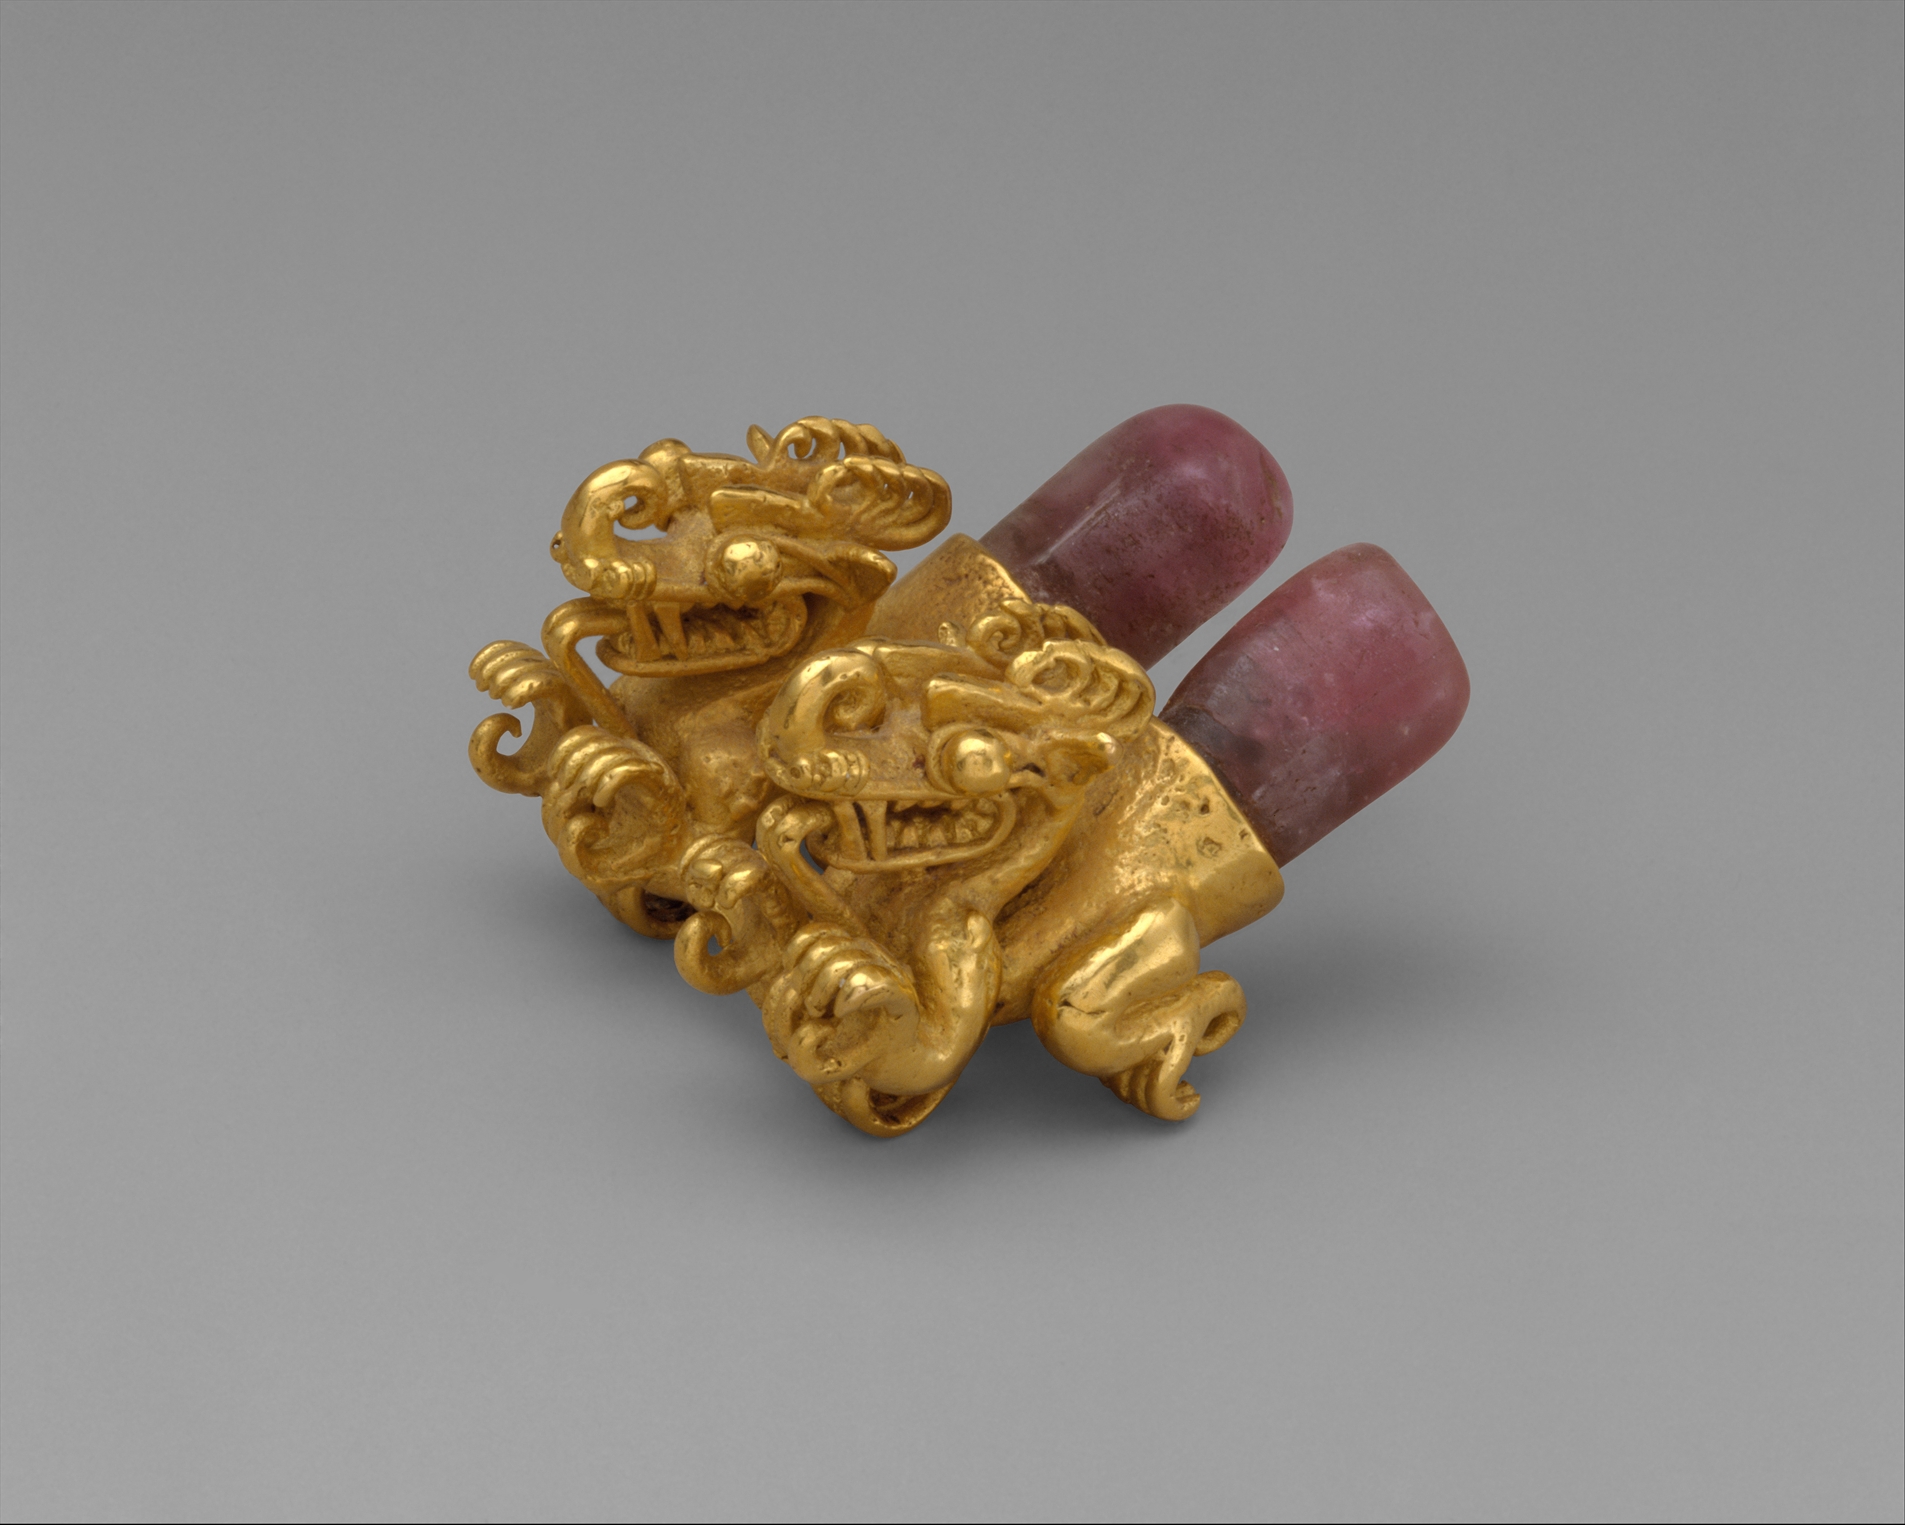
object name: pendant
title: Double crocodile pendant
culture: coclé, macaracas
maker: coclé (macaracas) artist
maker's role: artist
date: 950-1100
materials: gold, quartz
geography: panama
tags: crocodiles